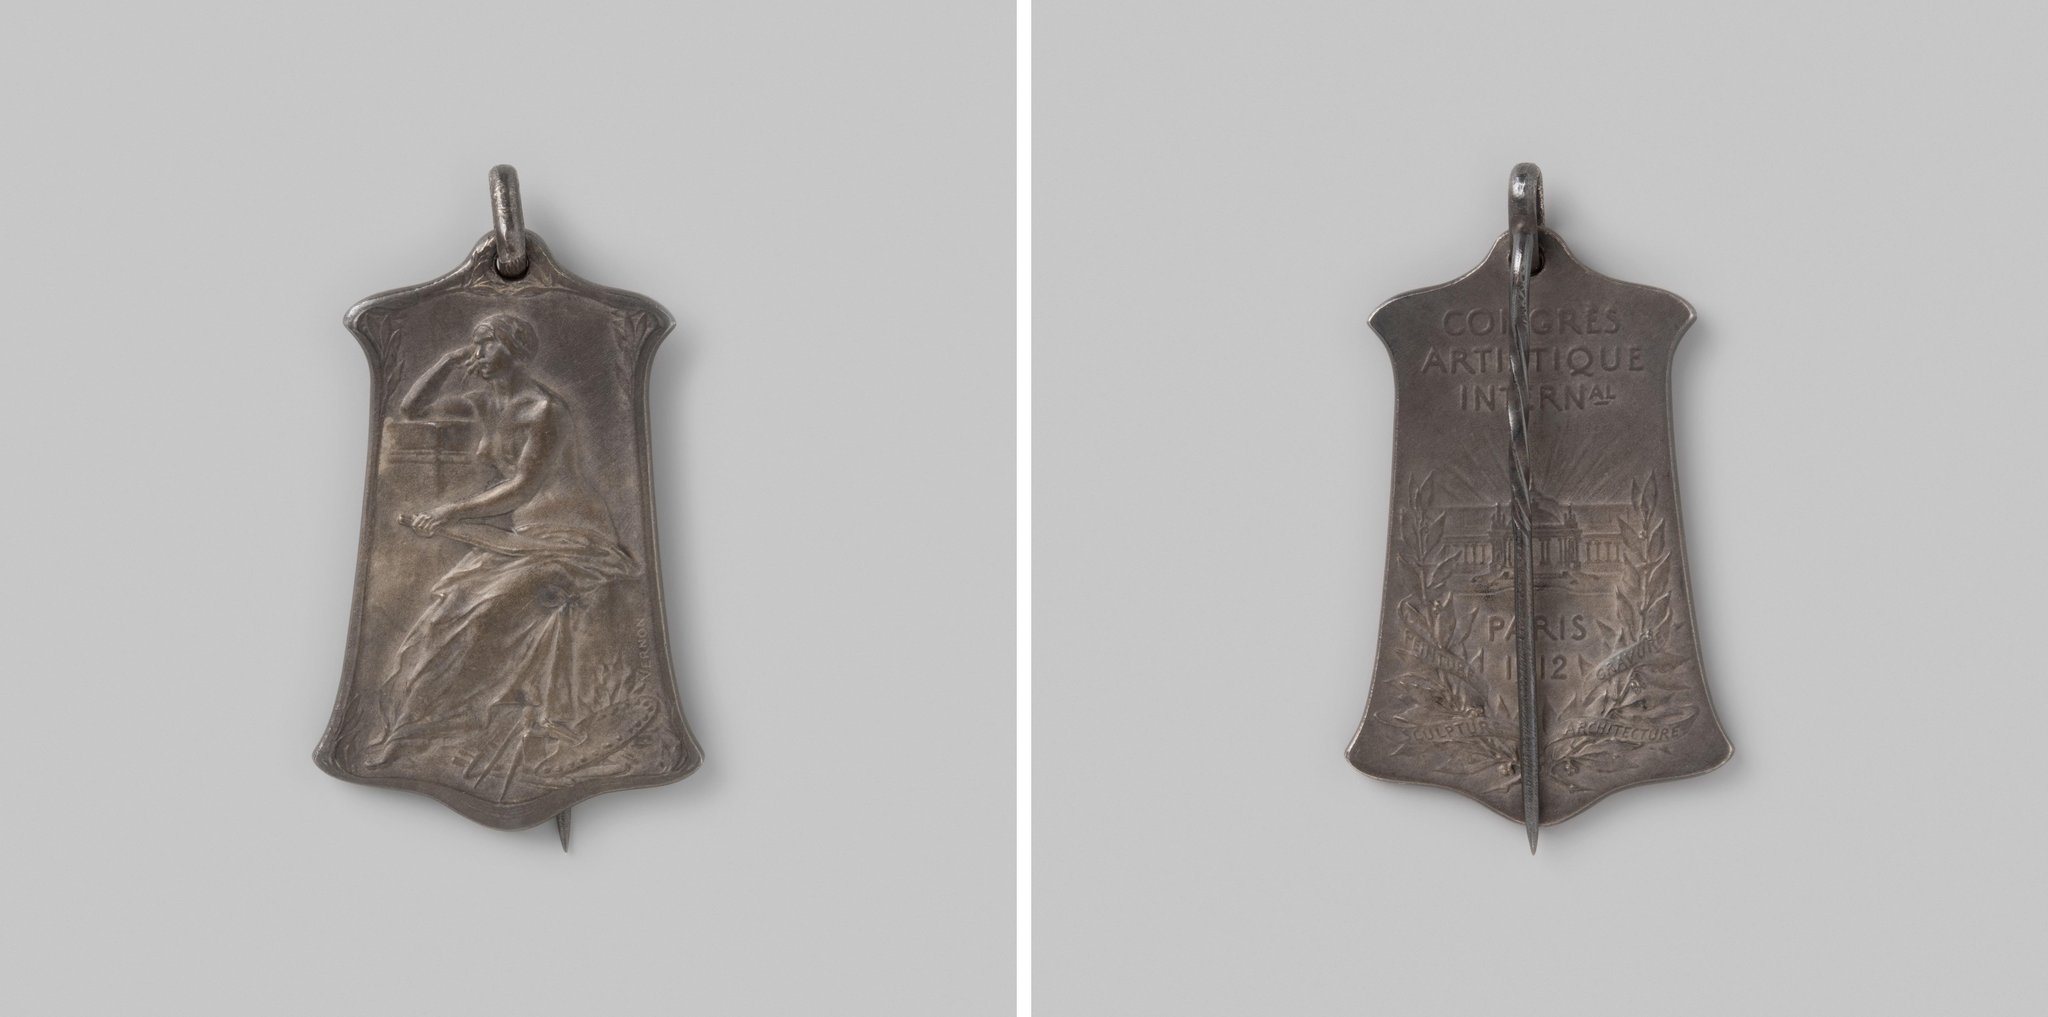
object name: insignia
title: Penning uitgereikt aan deelnemers van het internationaal kunstenaarscongres in Parijs, 1912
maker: frederic charles victor de vernon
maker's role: sculptor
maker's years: 1858-1912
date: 1912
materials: metal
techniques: striking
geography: france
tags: the hague, amsterdam, bart van hove, paris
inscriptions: inscription: ‘PEINTURE SCULPTURE GRAVURE ARCHITECTURE’, signature: ‘VERNON’, inscription: ‘CONGRES ARTISTIQUE INTERNAL PARIS 1912’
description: Langwerpige, klokvormige penning met draagpin aan draagoog. Voorzijde: zittende halfnaakte vrouw, wier rechterhand haar hoofd steunt en die op haar knieën een plat voorwerp vasthoudt met haar linkerhand. Aan haar voeten schildersgerei. Met signatuur. Keerzijde: gebouw waaronder een lauwerkrans met lint met opschrift. Boven en onder gebouw opschrift.